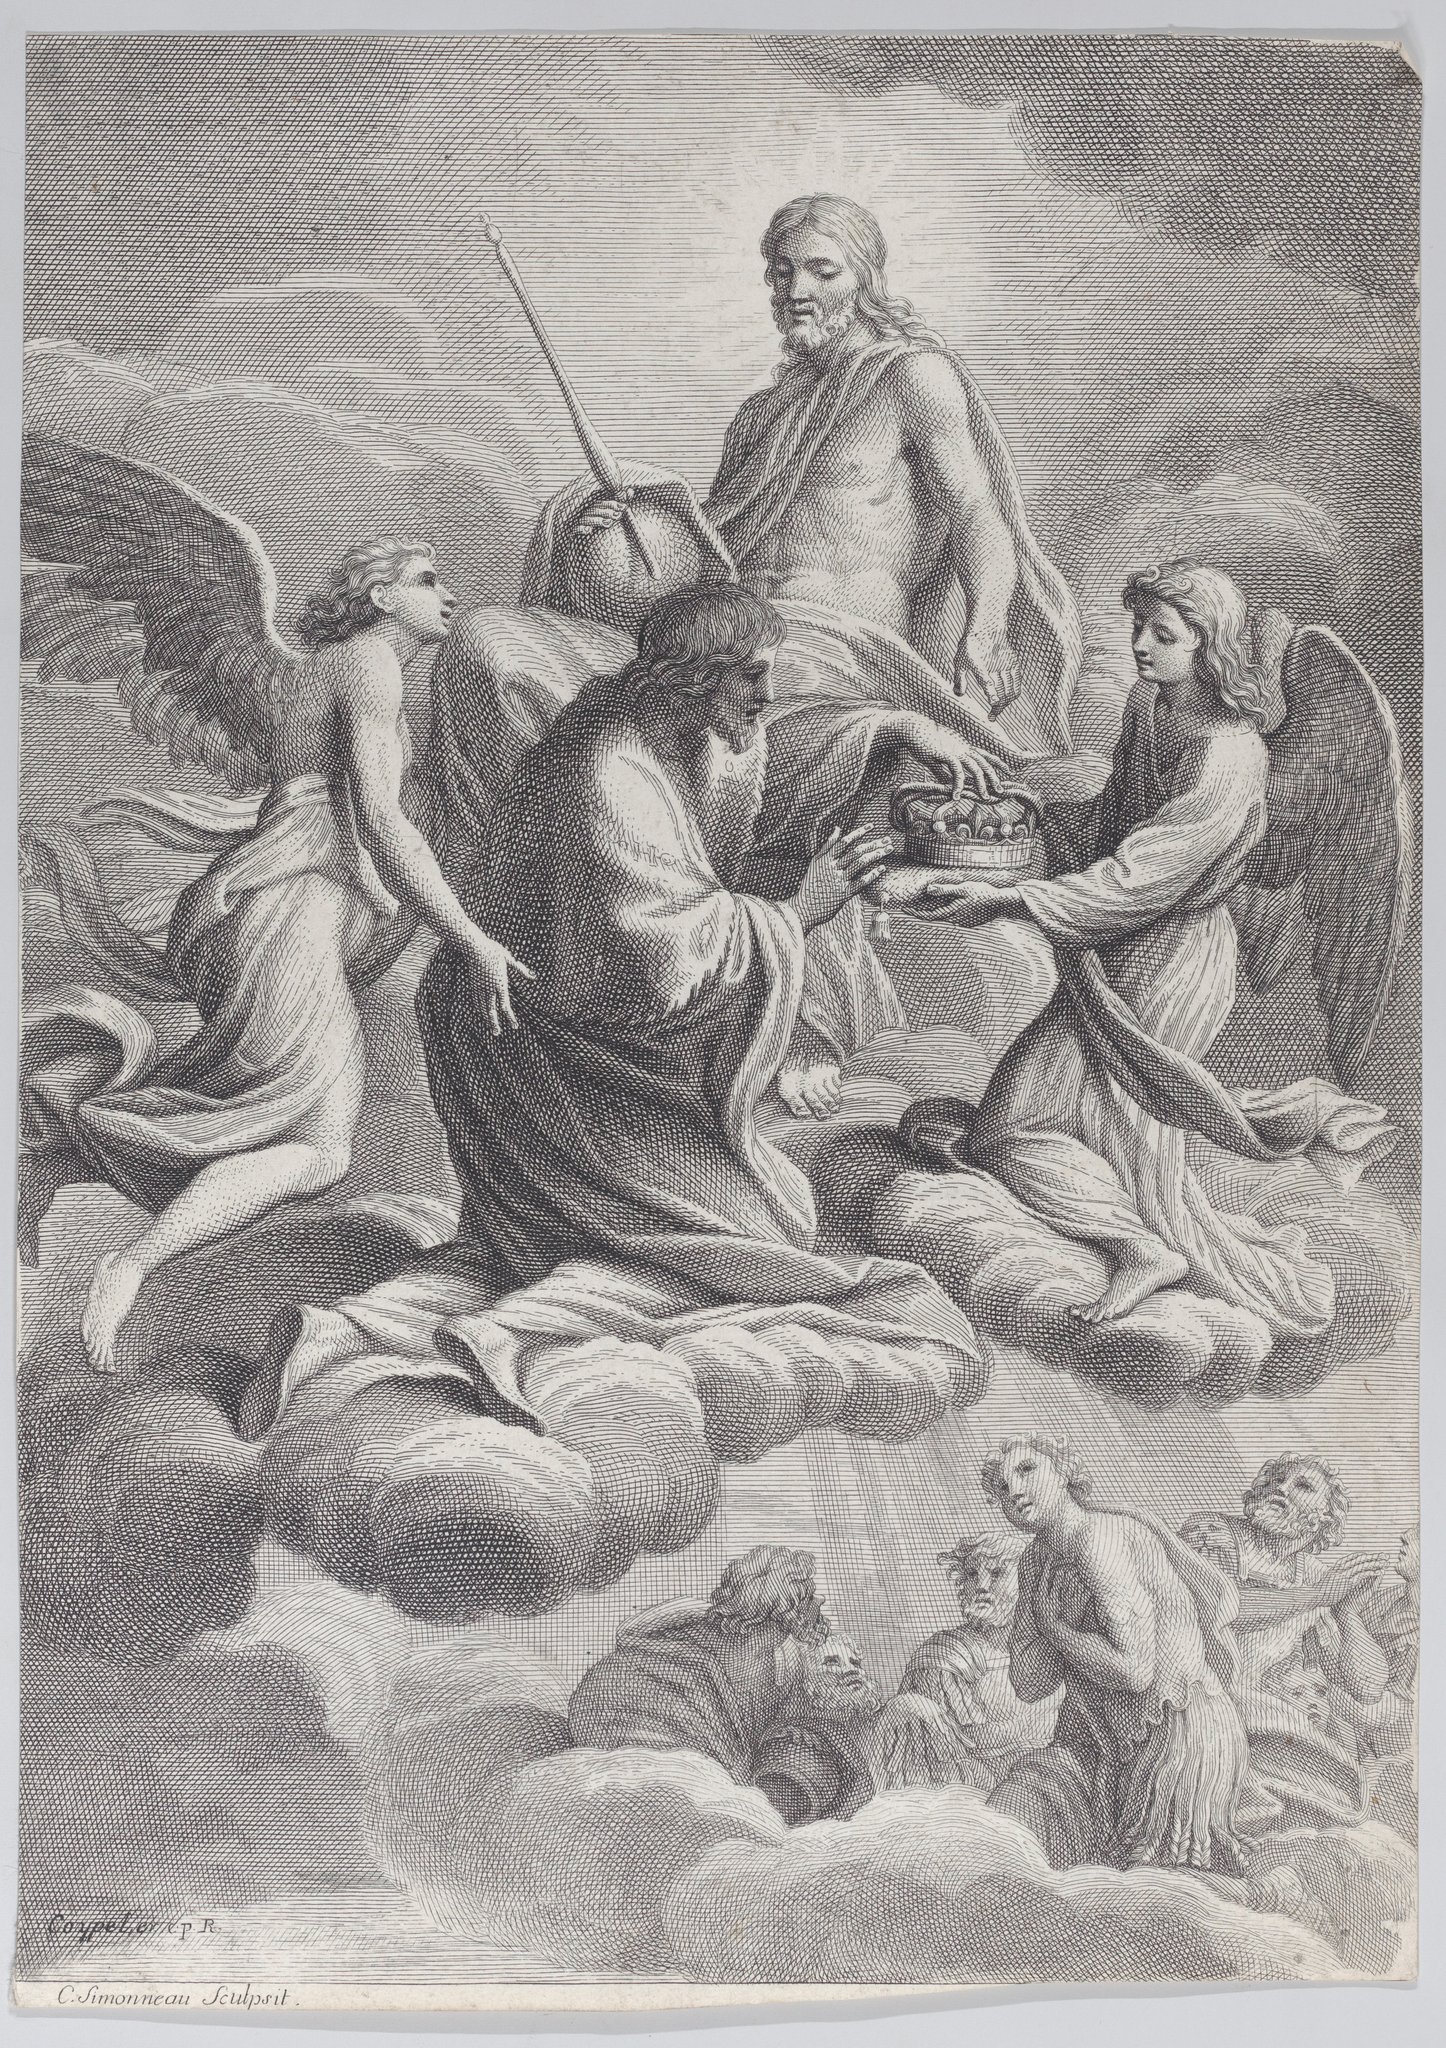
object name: print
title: Saint Louis of France received into heaven by Christ and two angels who offer him the crown of France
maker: charles simonneau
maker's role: artist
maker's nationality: french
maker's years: 1645-1728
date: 1671-1680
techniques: engraving